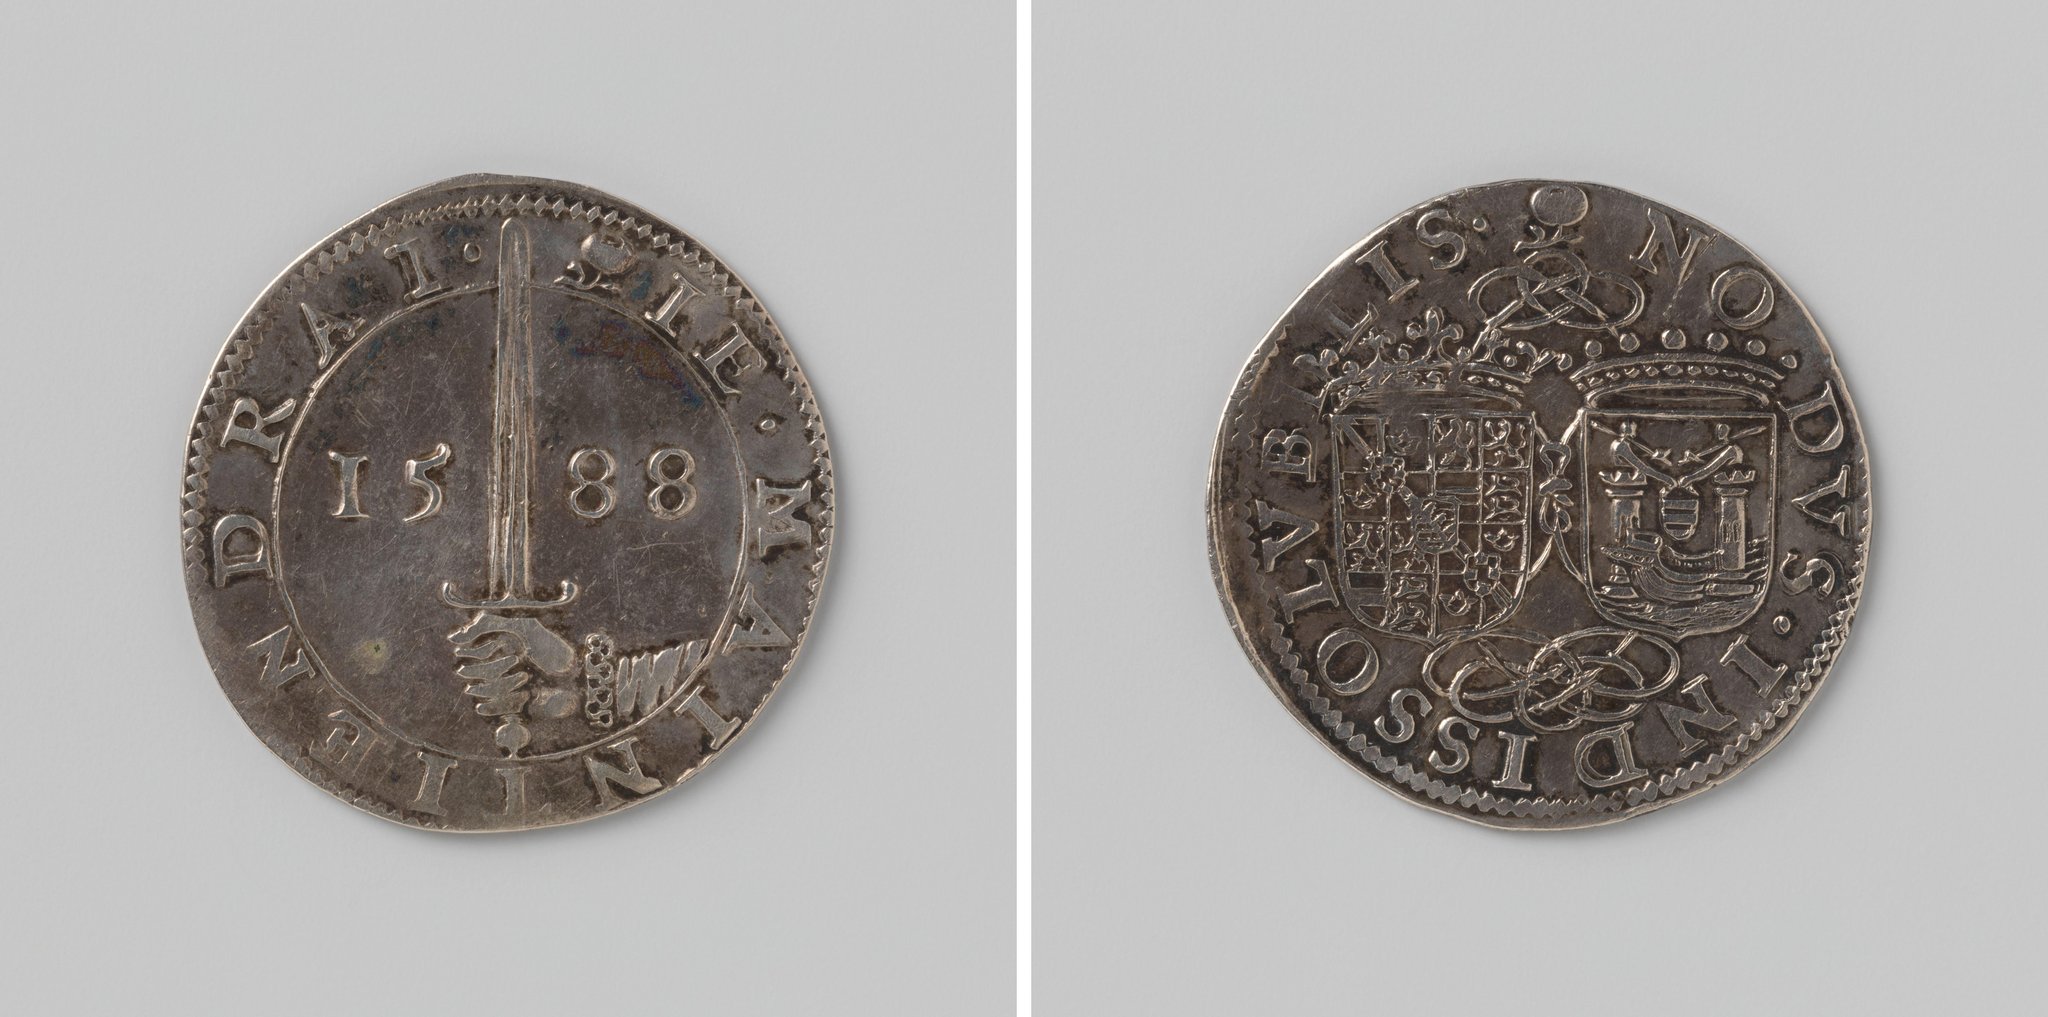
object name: strooipenning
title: Maurits van Oranje ingehuldigd als markgraaf van Kamperveer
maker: Anonymous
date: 1588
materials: silver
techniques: striking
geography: zeeland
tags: maurice (prince of orange)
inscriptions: circumscription: ‘JE MAINTIENDRAI’, date: ‘1588’, circumscription: ‘NO DVS INDISSOLVBILIS’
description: Zilveren penning. Voorzijde: hand met zwaard tussen jaartal binnen omschrift. Keerzijde: twee door linten met elkaar verbonden gekroonde wapenschilden binnen omschrift.